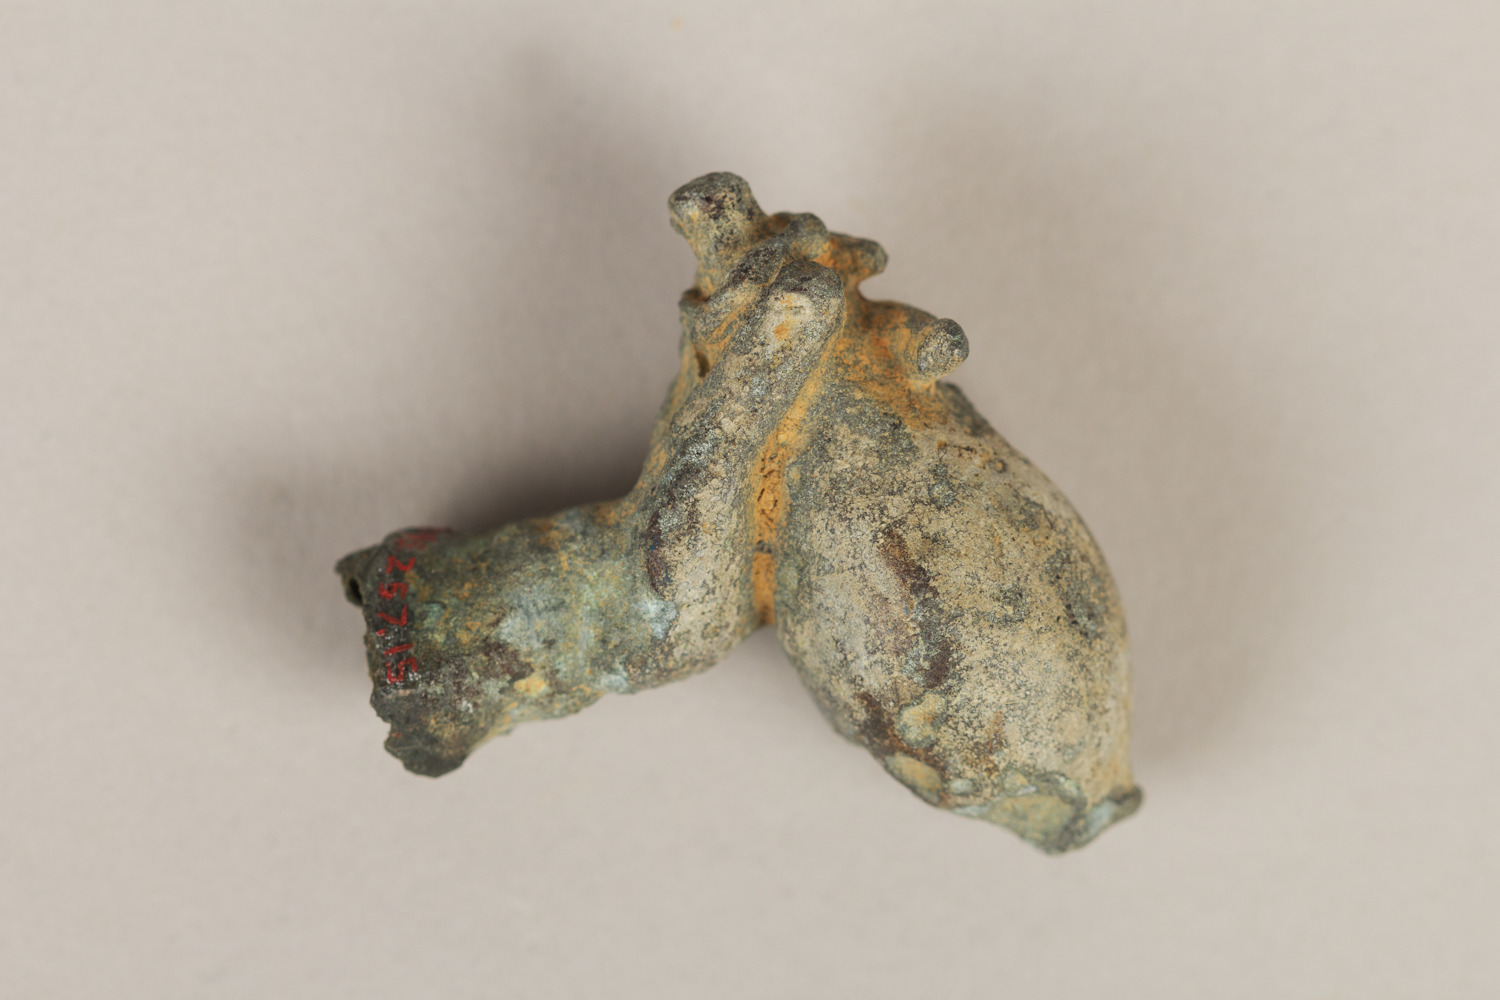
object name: fragment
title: Fragment of a Wrist and Hand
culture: indonesian, kalimantan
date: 701-800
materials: bronze